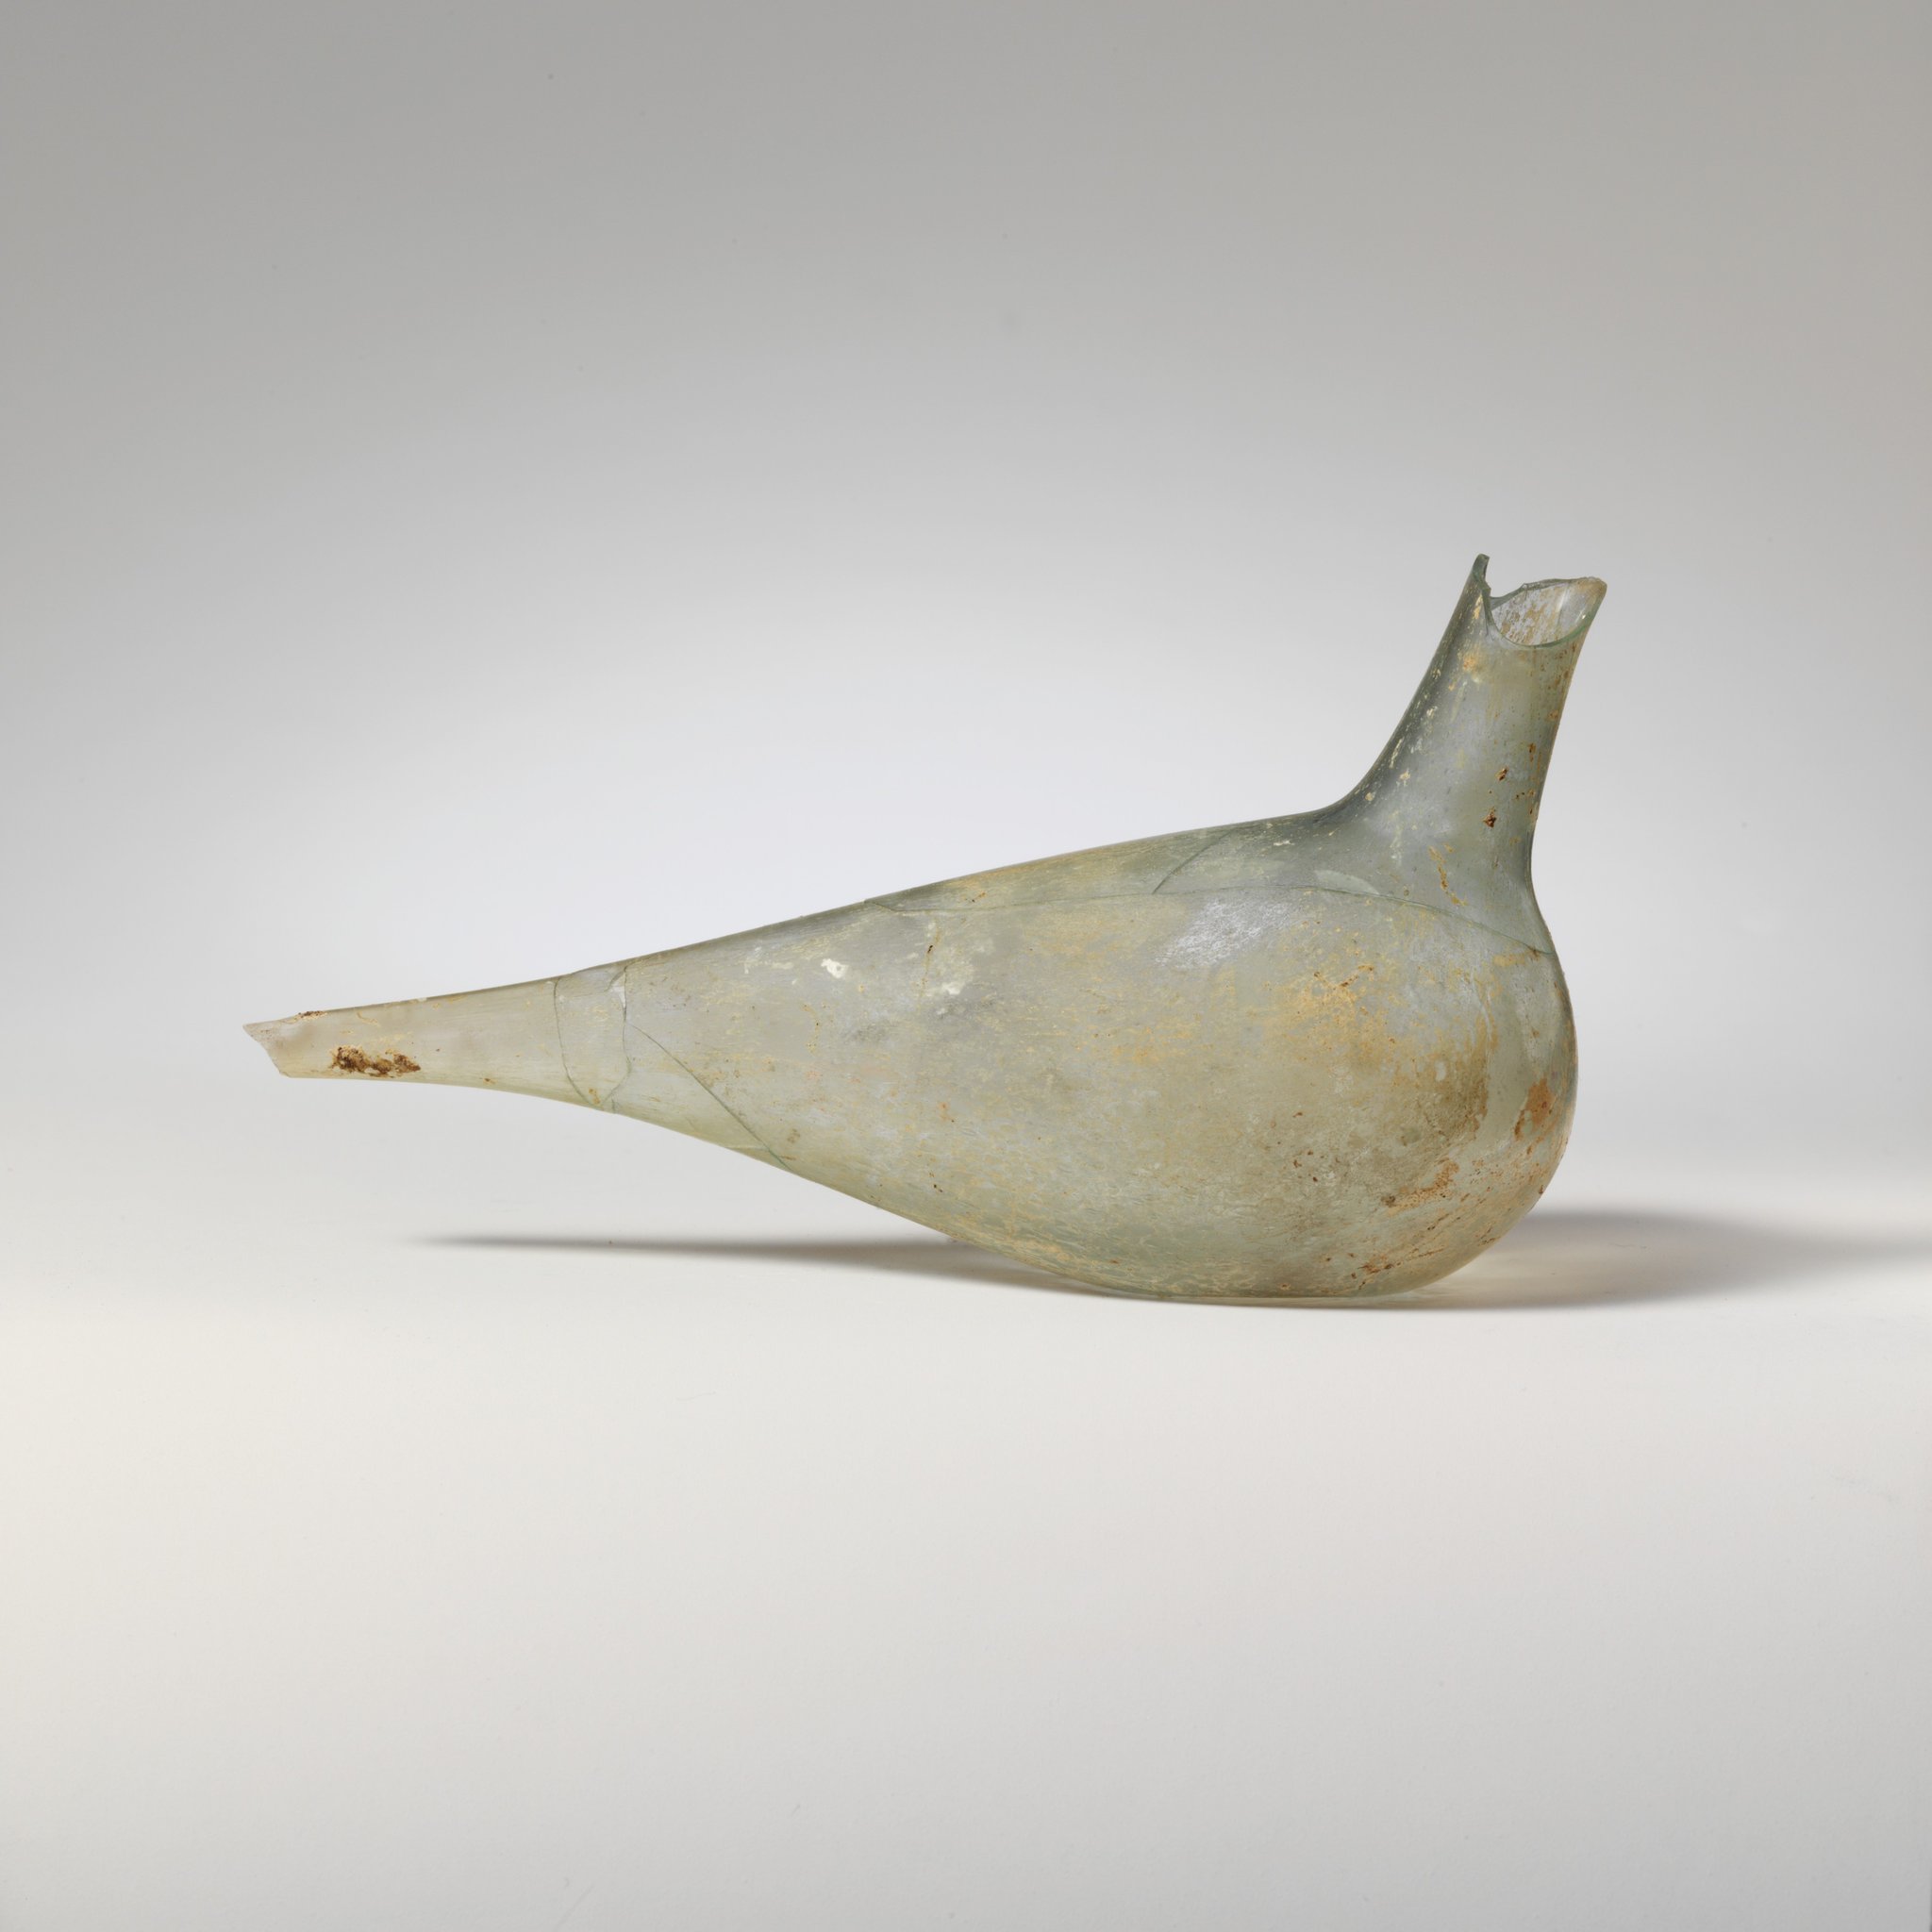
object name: bottle in the form of a bird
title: Glass bottle shaped like a bird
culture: roman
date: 1-100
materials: glass